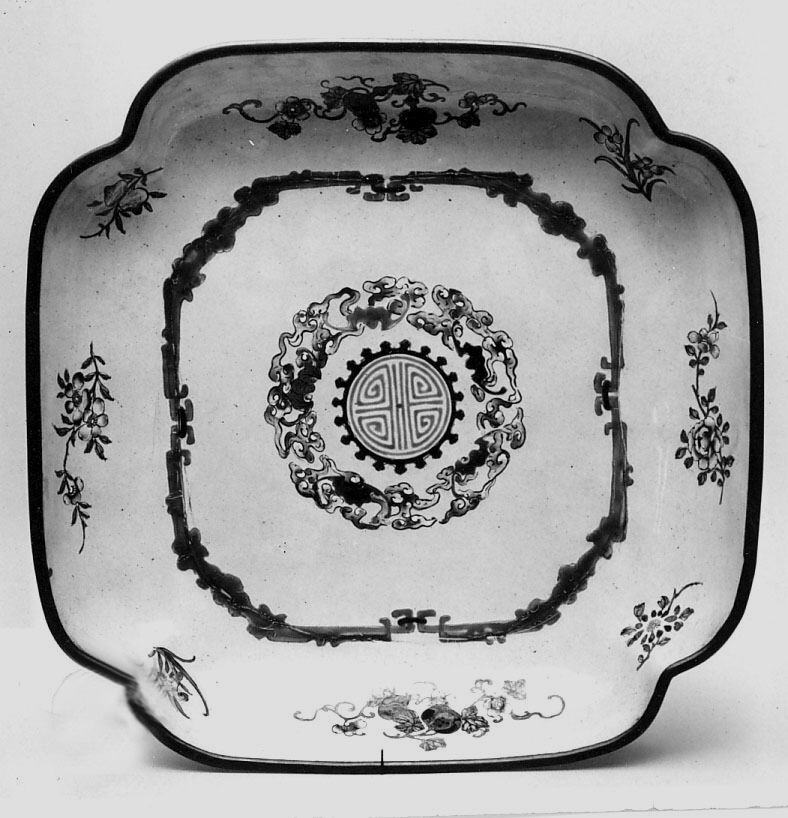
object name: dish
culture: chinese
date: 1801-1900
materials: enamel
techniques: painting